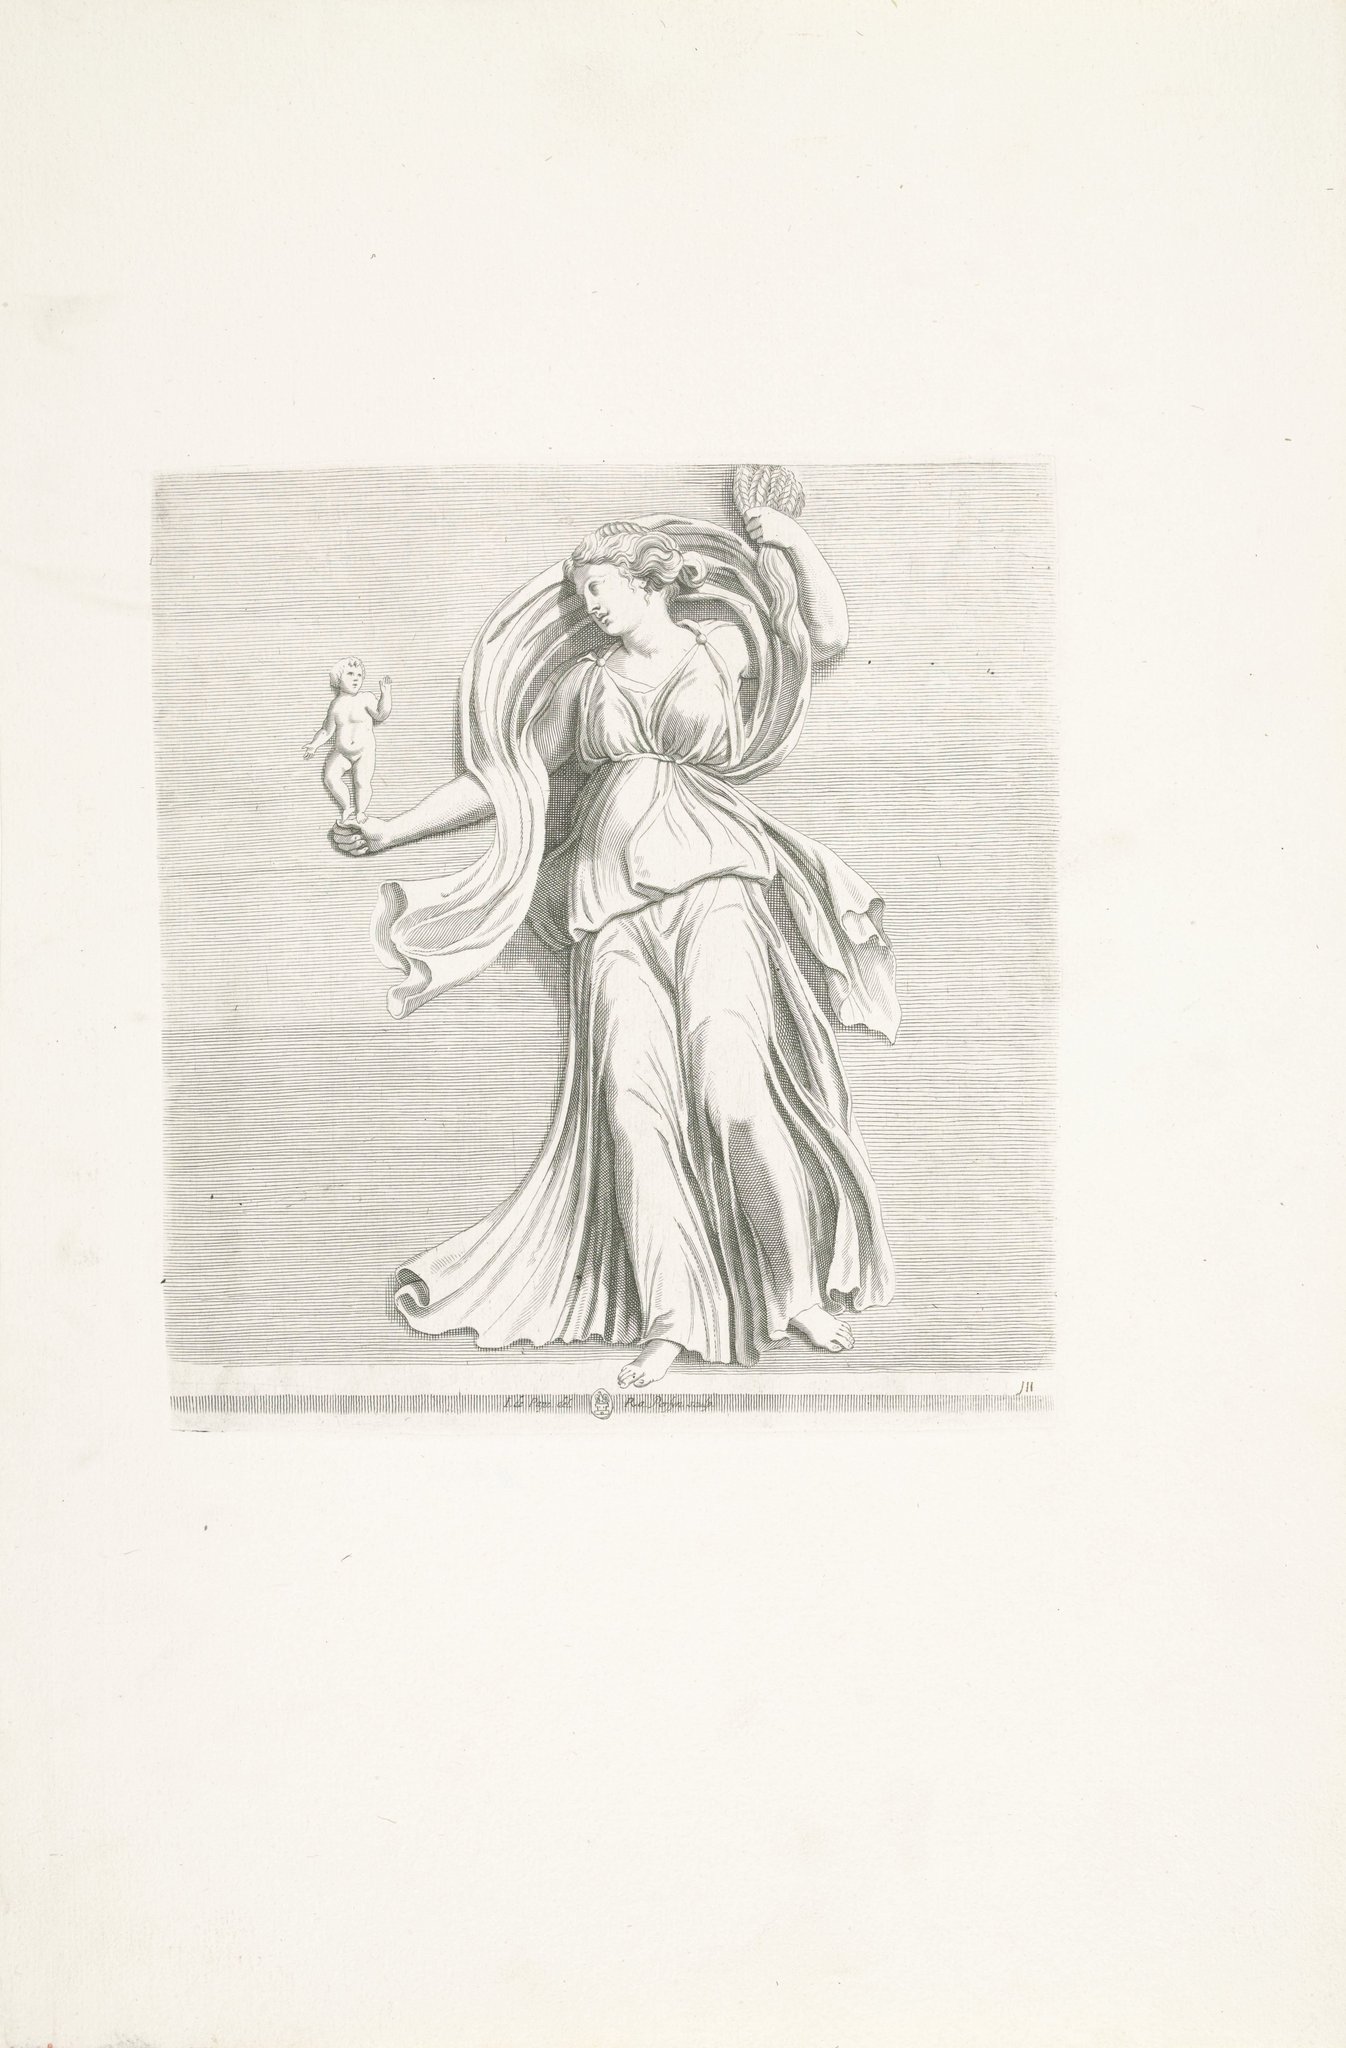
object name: print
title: Bas-reliëf van Ceres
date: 1640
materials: paper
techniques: engraving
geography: rome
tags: rome, vincenzo giustiniani (1564-1637), (story of) ceres (demeter), piece of sculpture, reproduction of a piece of sculpture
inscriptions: collector's mark: Lugt 2228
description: Romeins bas-reliëf van Ceres, de godin van de landbouw, met korenaren in de hand. Op haar andere hand balanceert een putto. Midden onder het wapenschild van Vincenzo Giustiniani. Prent uit een publicatie met reproductieprenten naar de sculpturen in de verzameling in de Galleria Giustiniani te Rome.